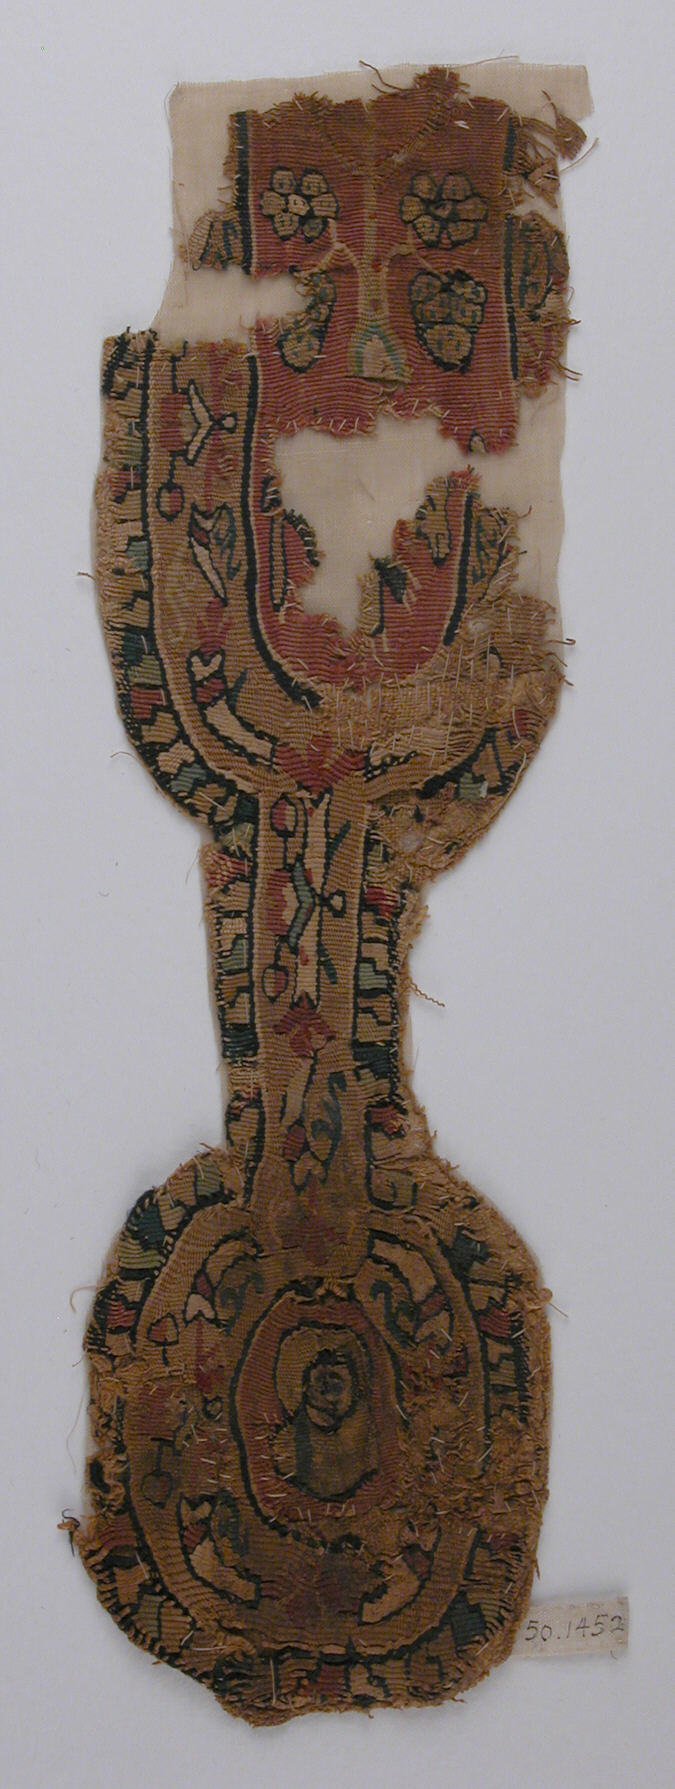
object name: shoulder band fragment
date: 501-700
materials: linen, wool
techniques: weave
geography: egypt